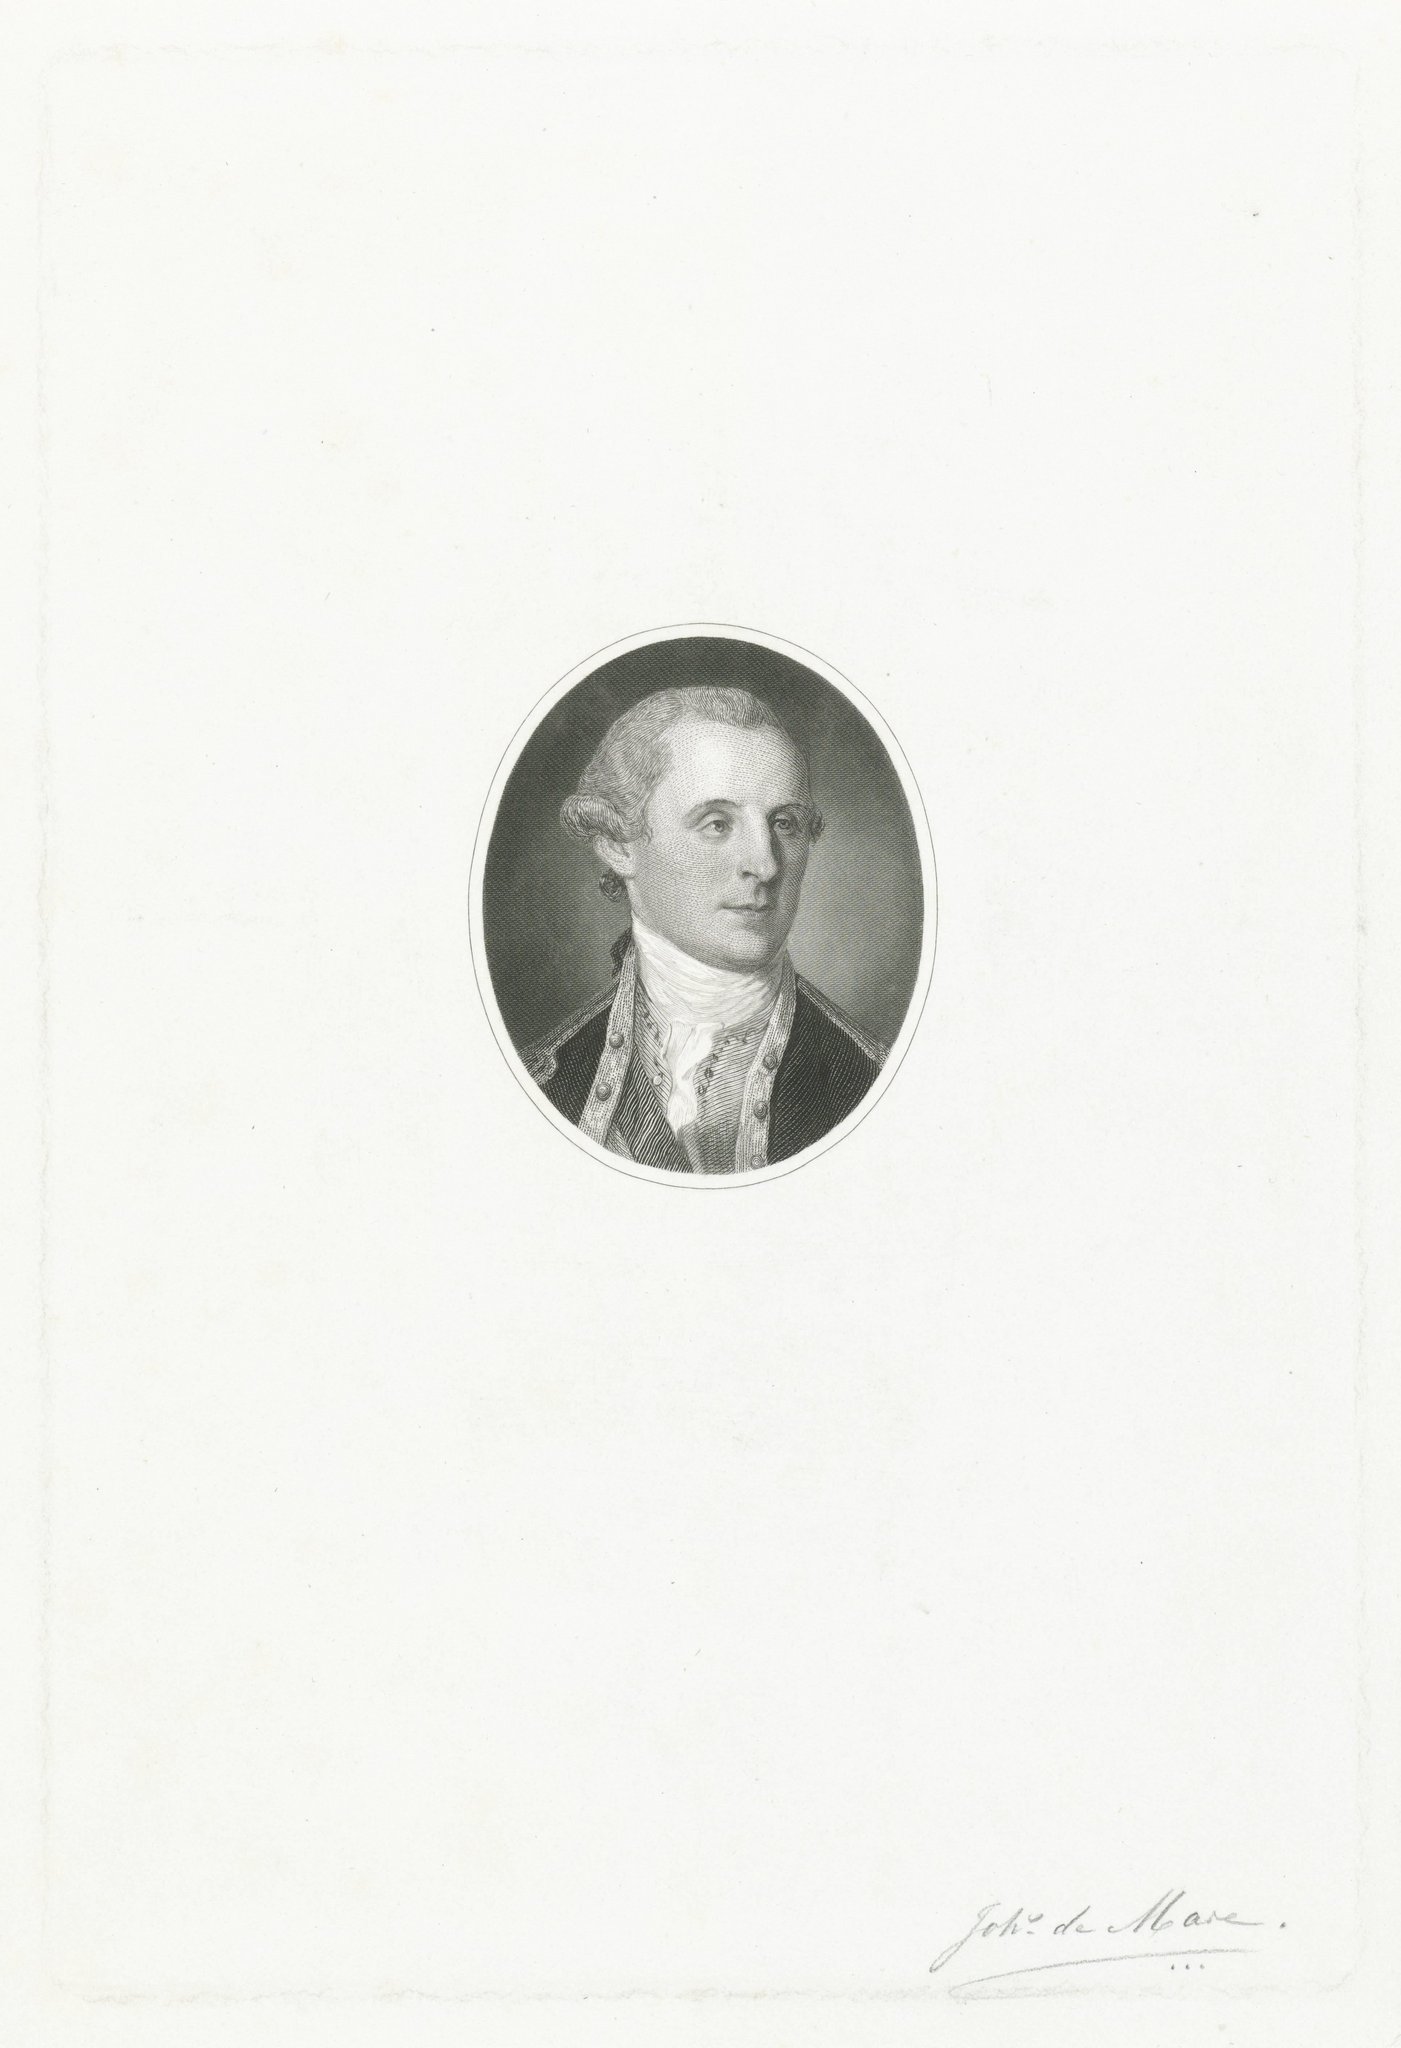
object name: print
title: Portret van een onbekende man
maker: johannes de mare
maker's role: draughtsman, print maker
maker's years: 1806-1889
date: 1816-1889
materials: paper, pencil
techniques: engraving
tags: adult man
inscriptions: collector's mark: Lugt 2228